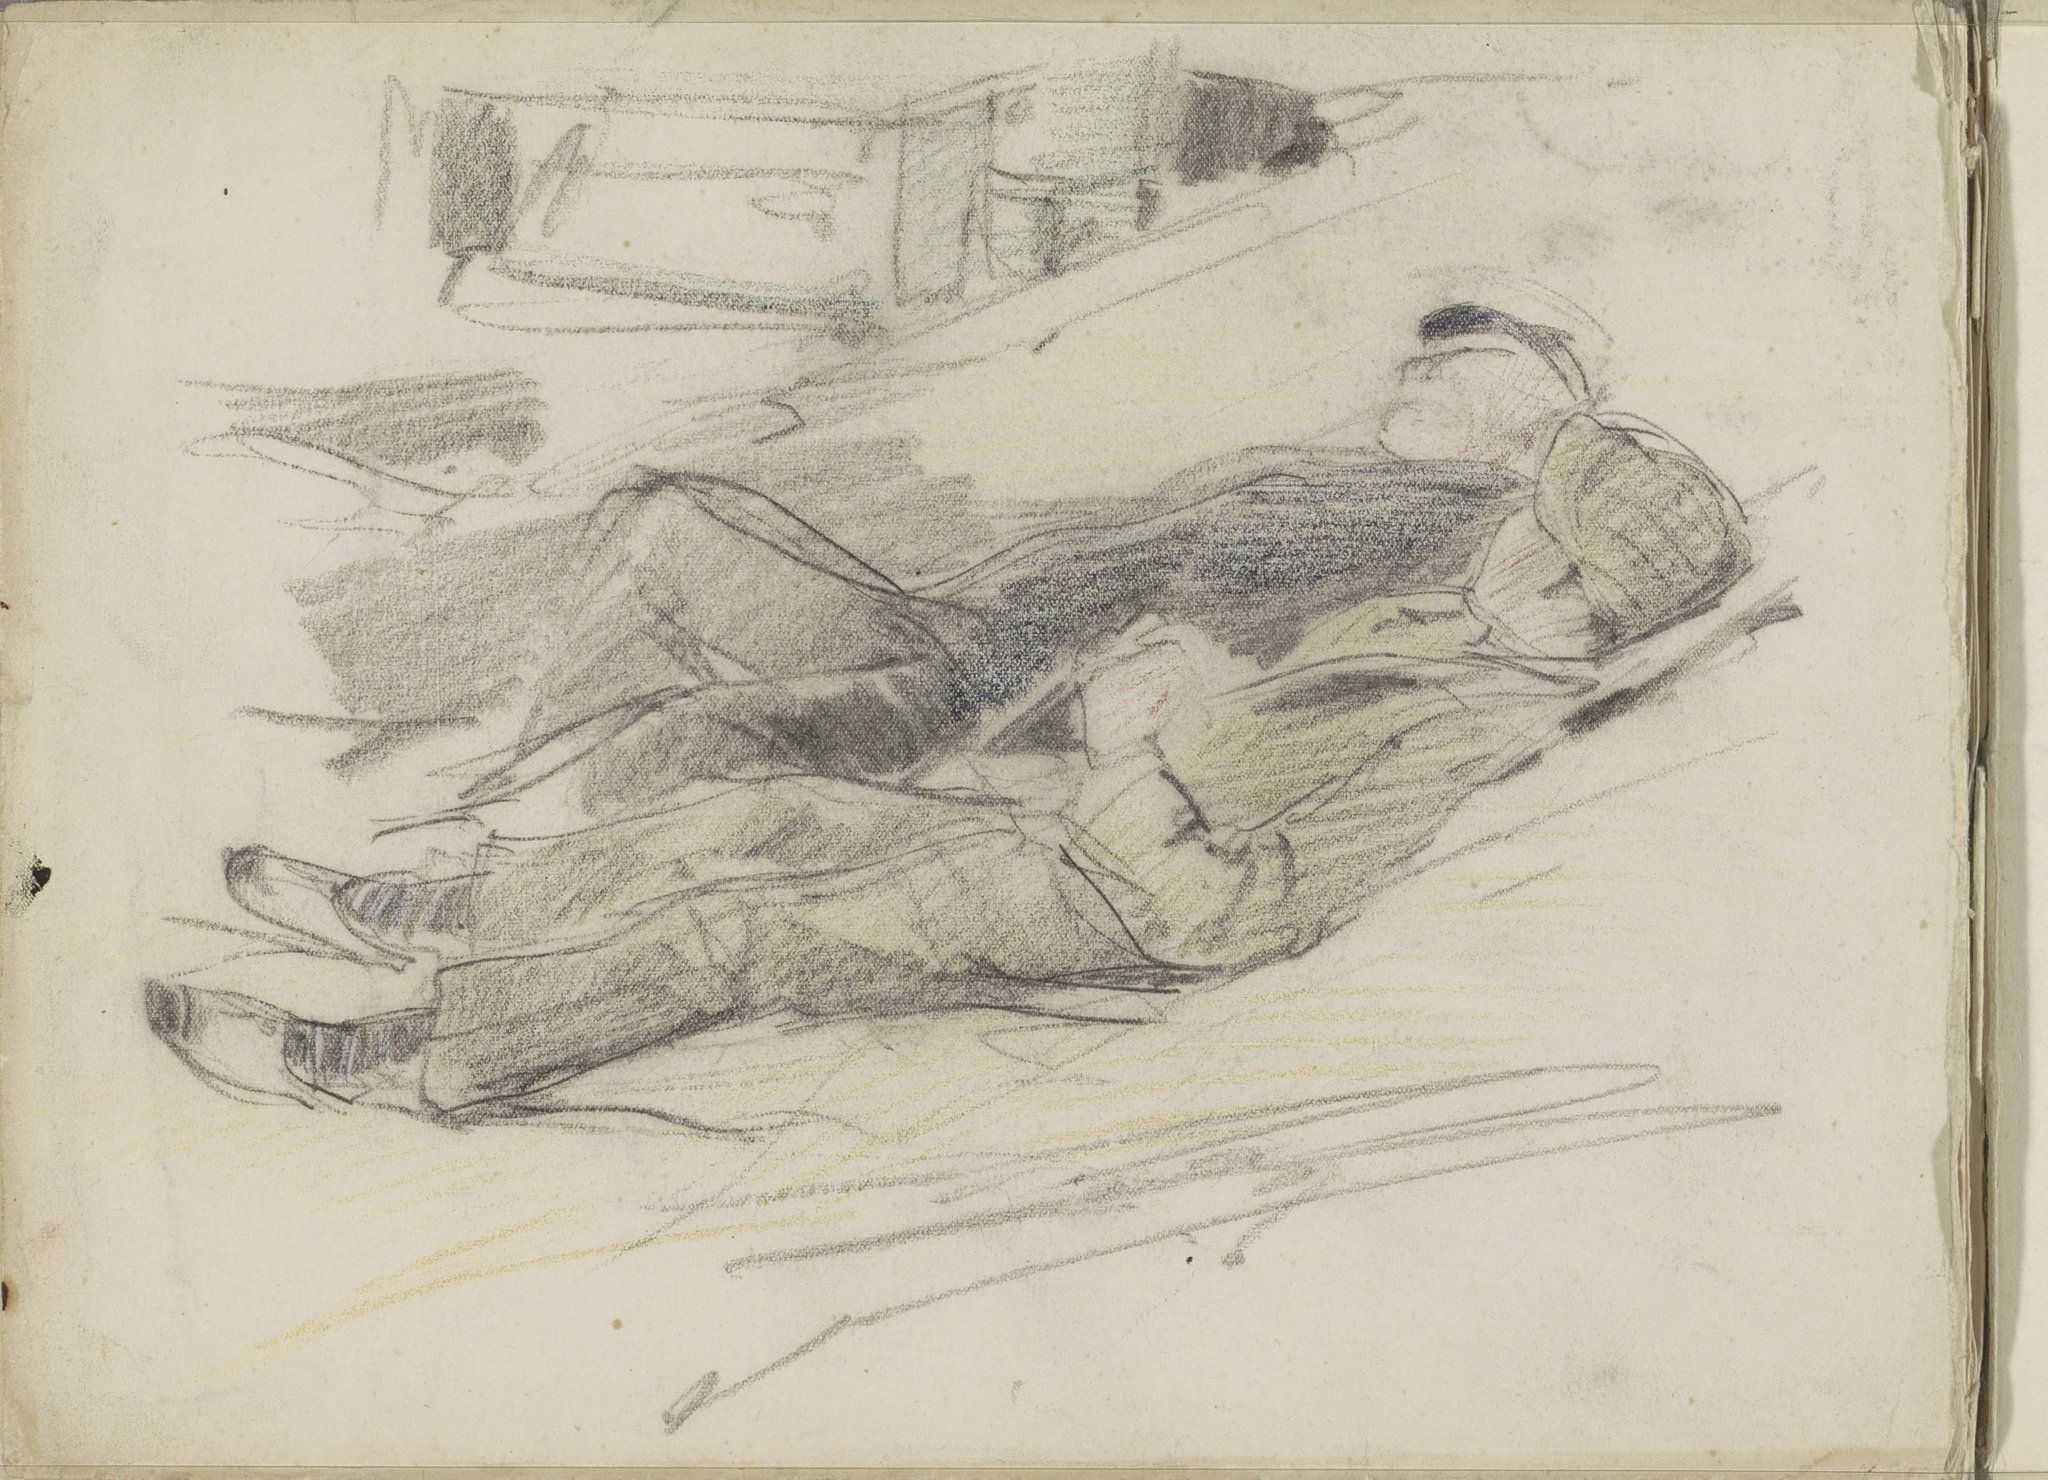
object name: sketchbook leaf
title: Twee liggende mannen op het strand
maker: monogrammist ds (tekenaar)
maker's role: draughtsman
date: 1850-1950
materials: chalk, paper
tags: beach (as place of recreation), lying figure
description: Blad 17 verso uit een schetsboek met 17 bladen.